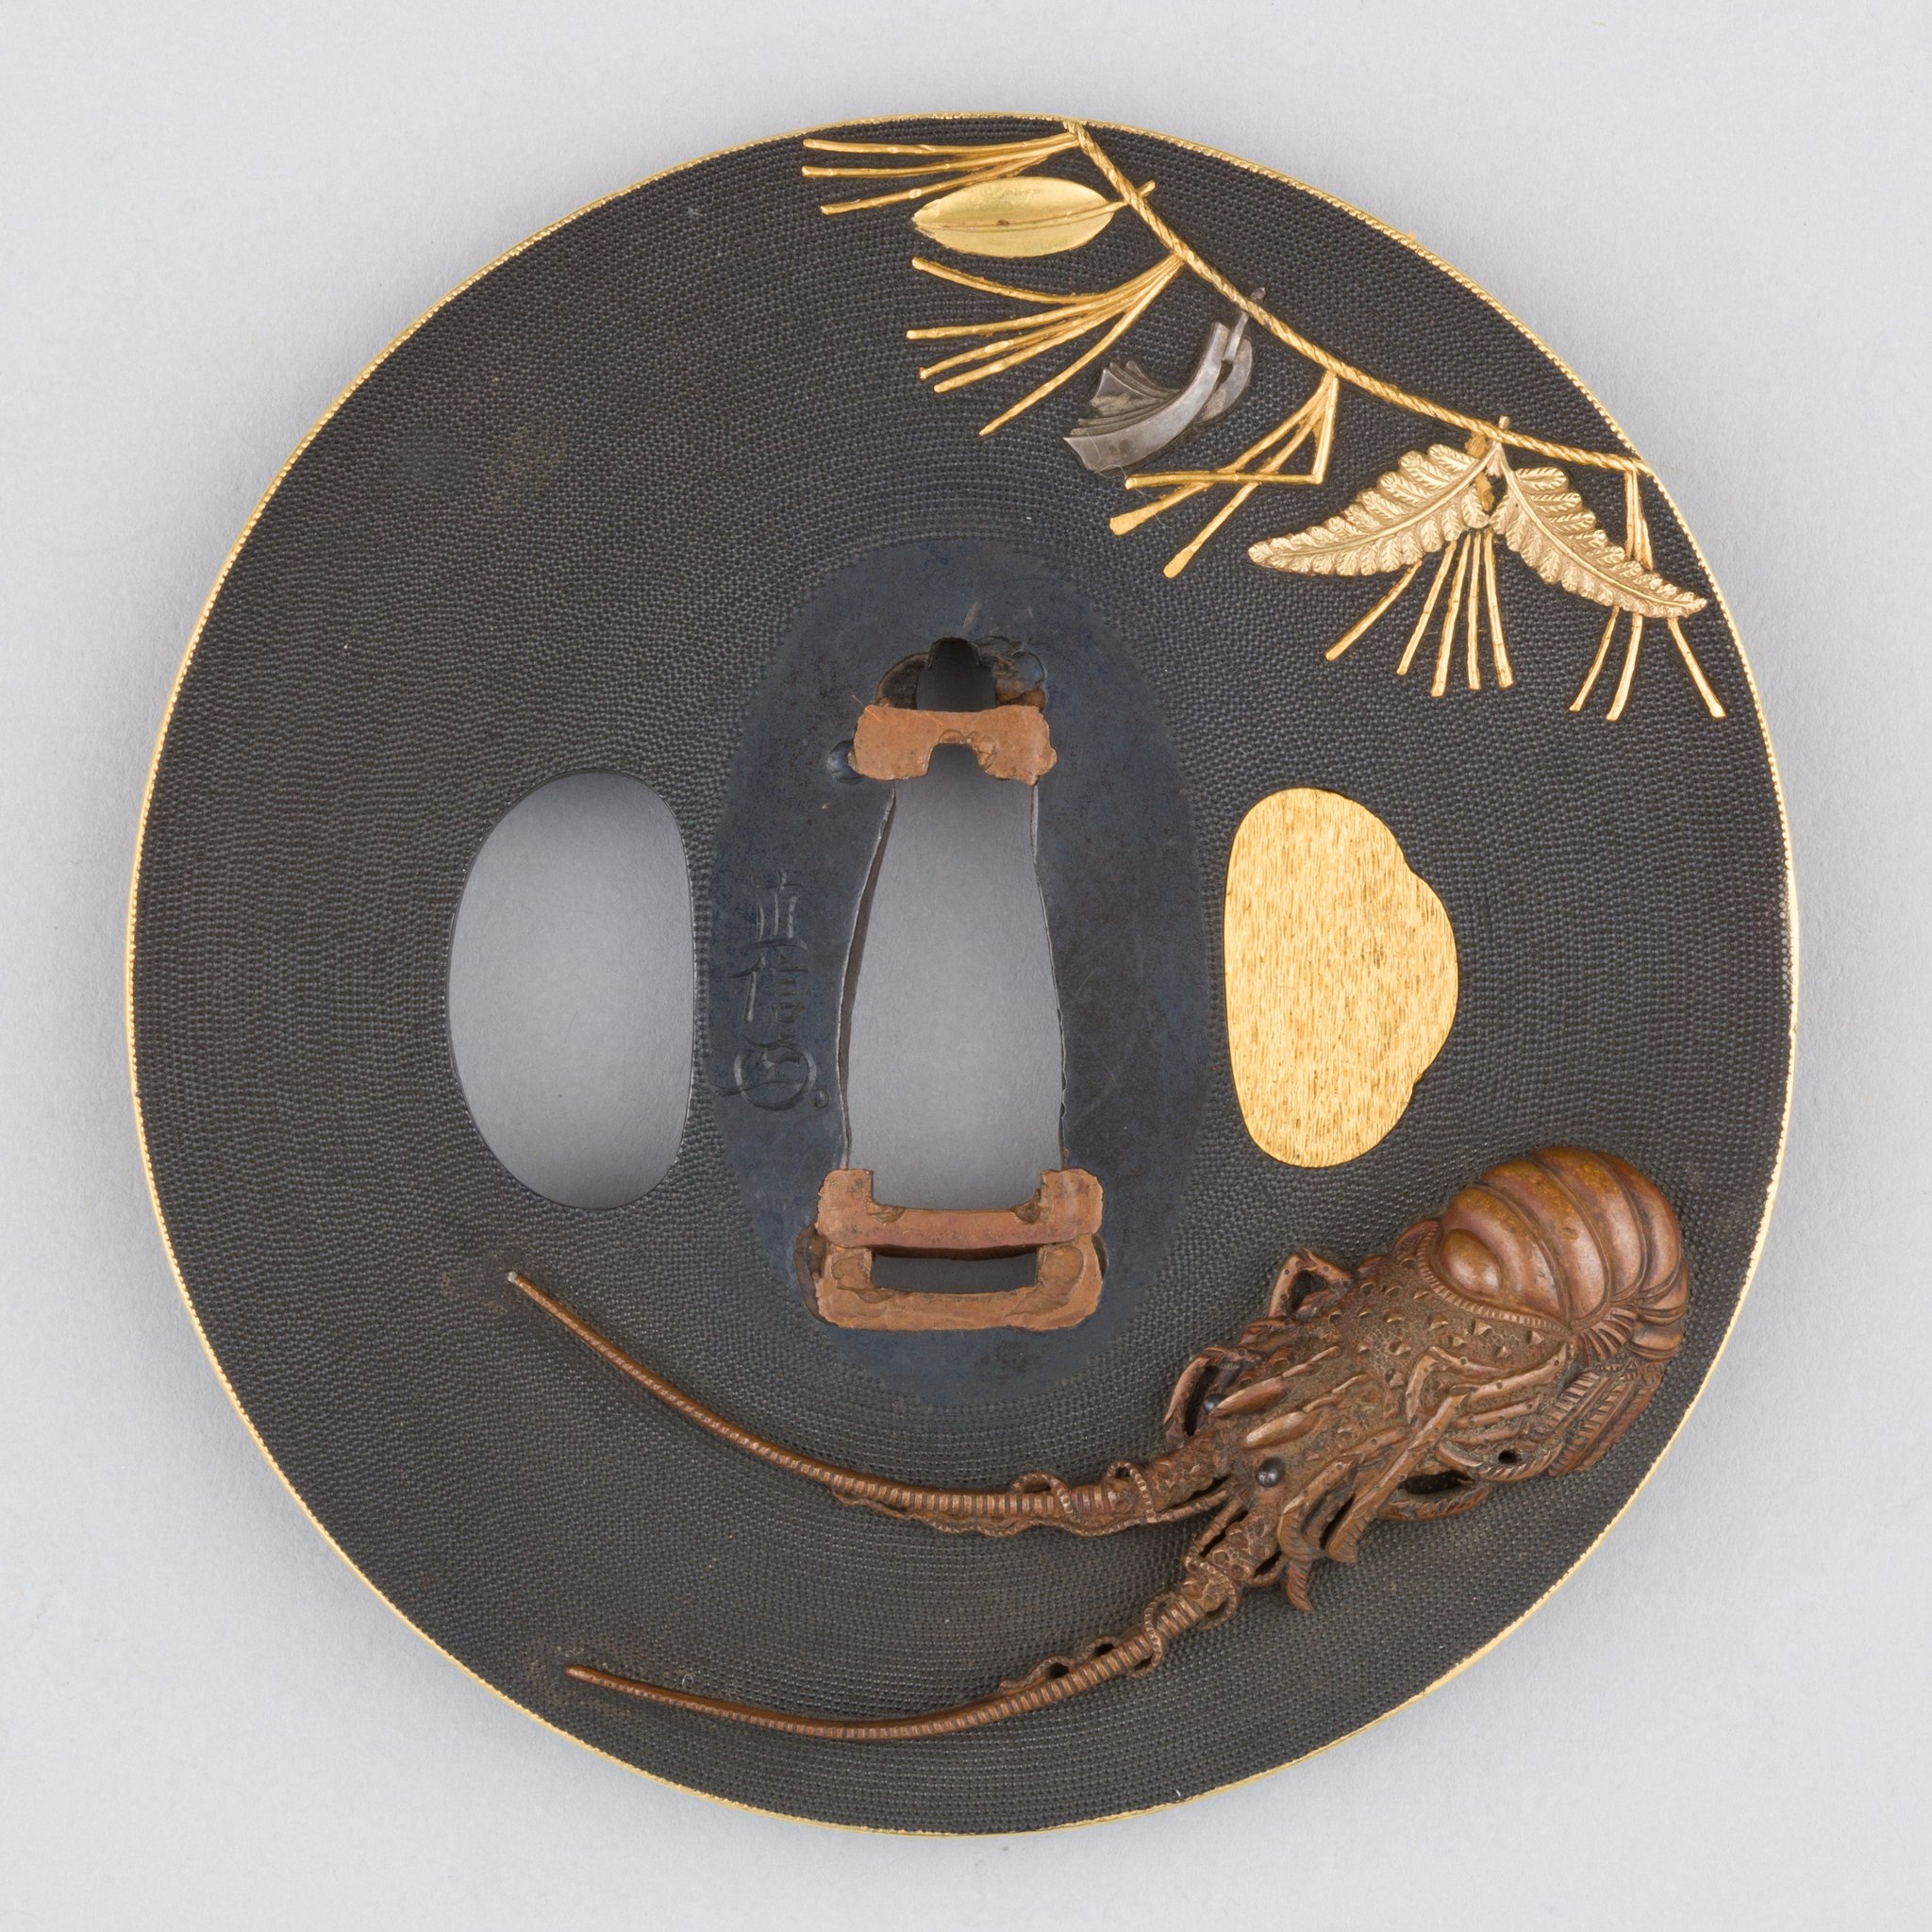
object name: sword guard tsuba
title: Sword Guard (Tsuba)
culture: japanese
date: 1615-1868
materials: copper, gold alloy, gold, silver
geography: japan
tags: lobsters